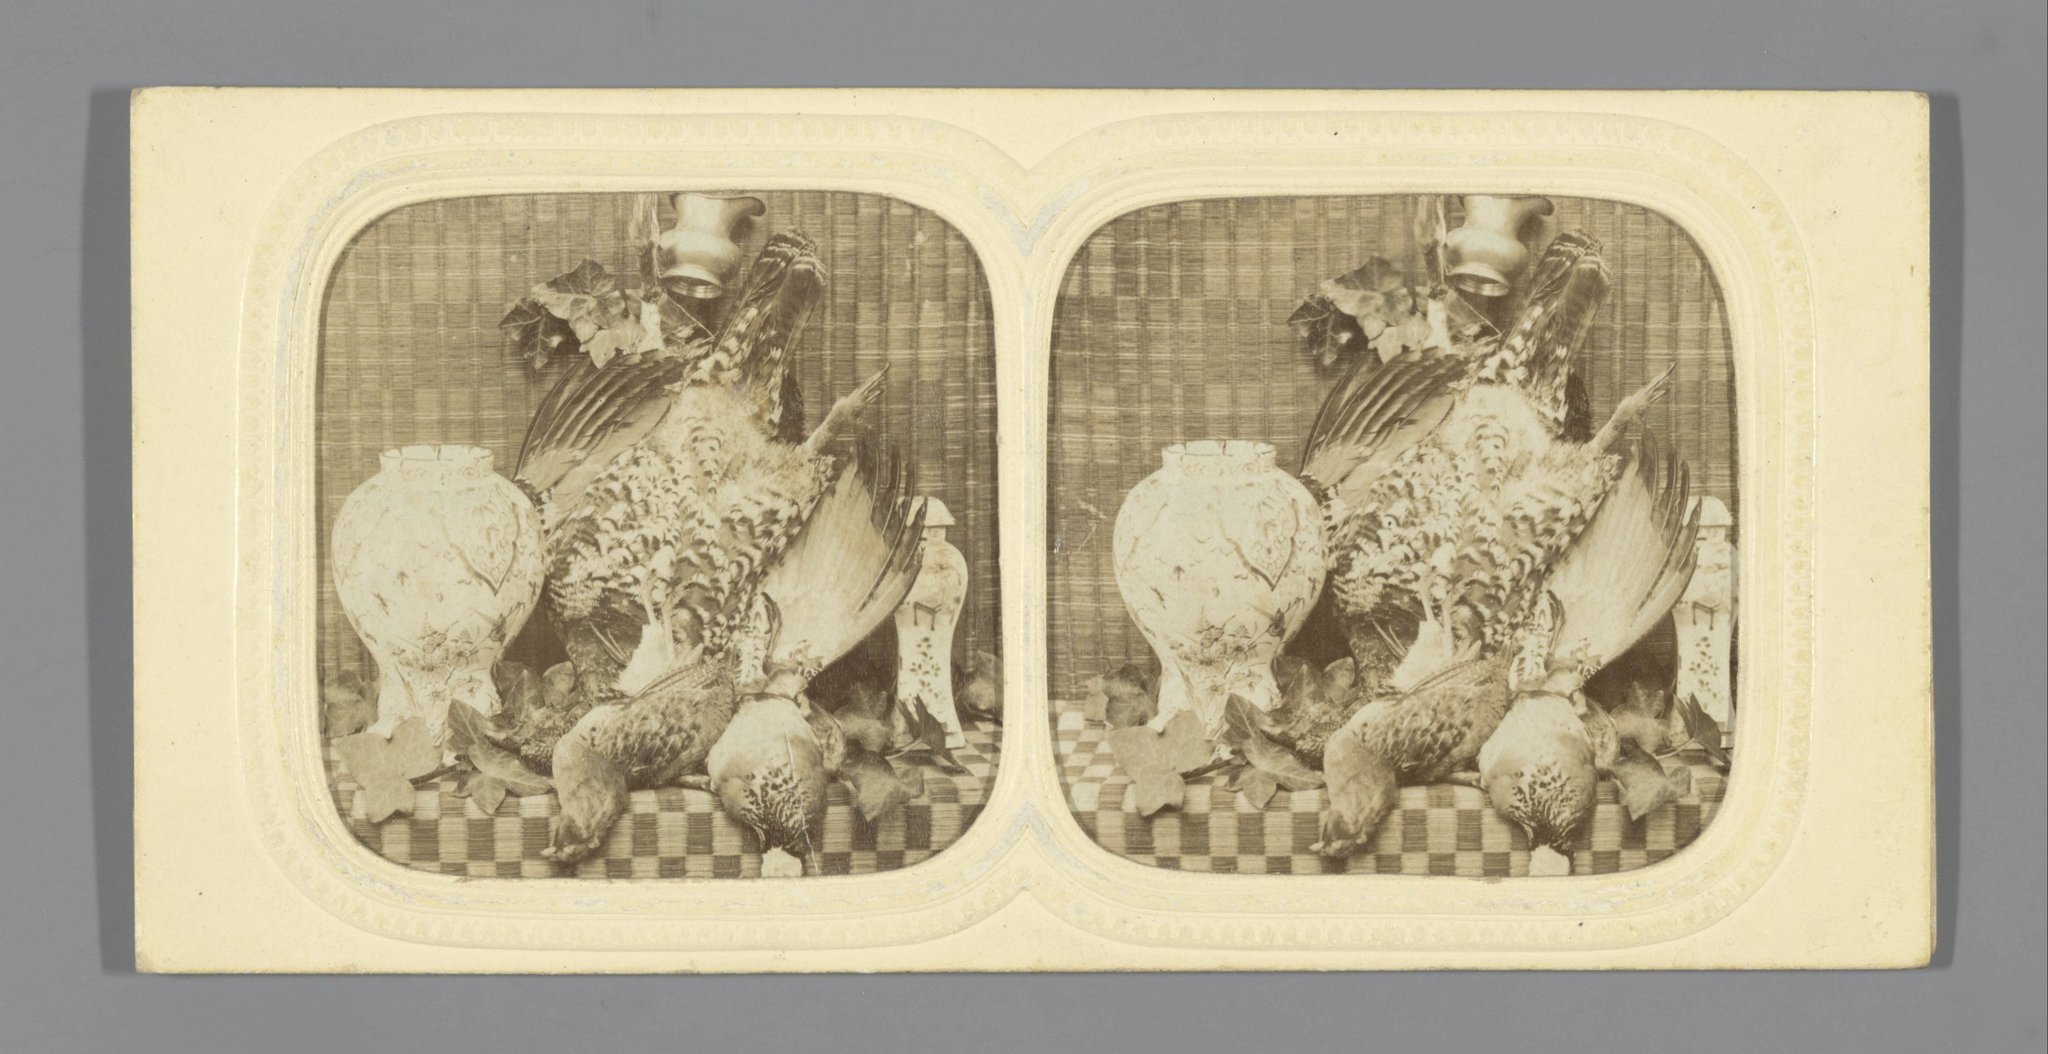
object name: tissue stereograph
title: Stilleven met gevogelte en vazen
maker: Anonymous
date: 1855-1875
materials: cardboard, paper, photographic support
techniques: albumen print, hand coloring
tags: still life of miscellaneous objects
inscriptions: retailer's mark: ‘AUGUSTE DEMMIN,/ Exportateur,/ Rue d'Angoulême, 6.-Paris./ No 50275 [...]’